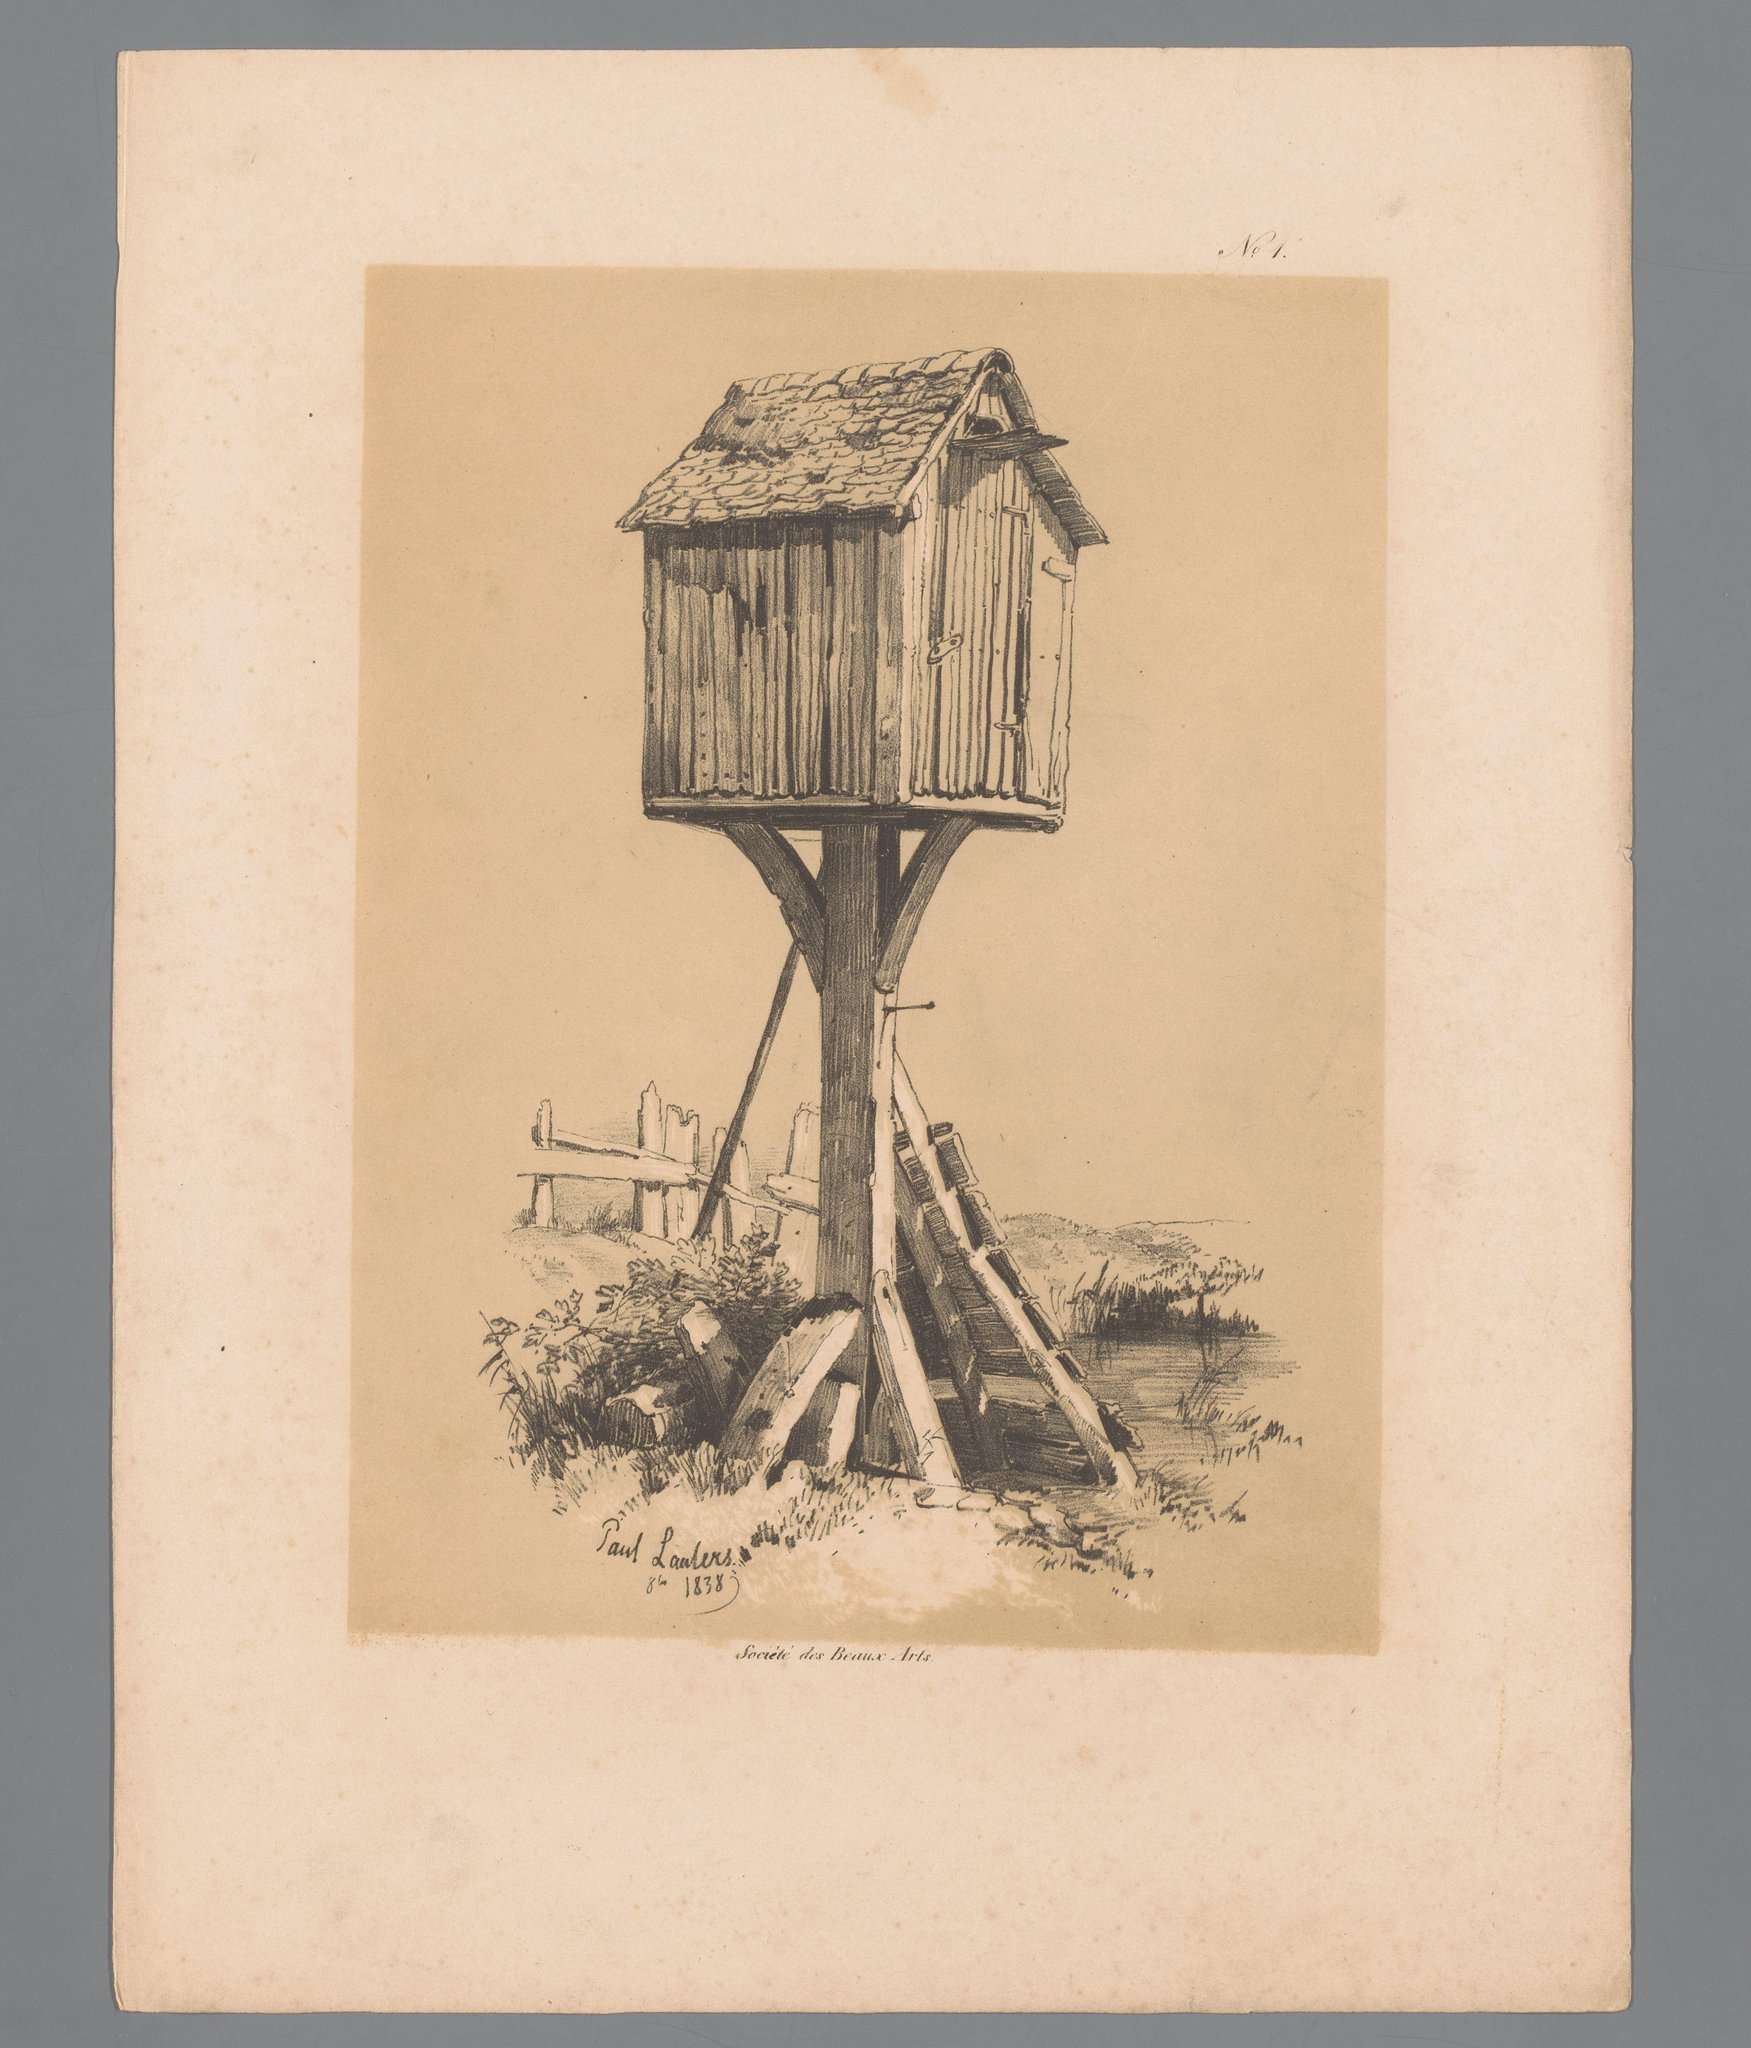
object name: print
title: Etrennes pittoresques pour 1839, par Lauters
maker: paulus lauters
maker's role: print maker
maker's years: 1806-1875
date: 1838-1839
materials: paper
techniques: tone lithography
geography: brussels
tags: landscapes, dove-cote